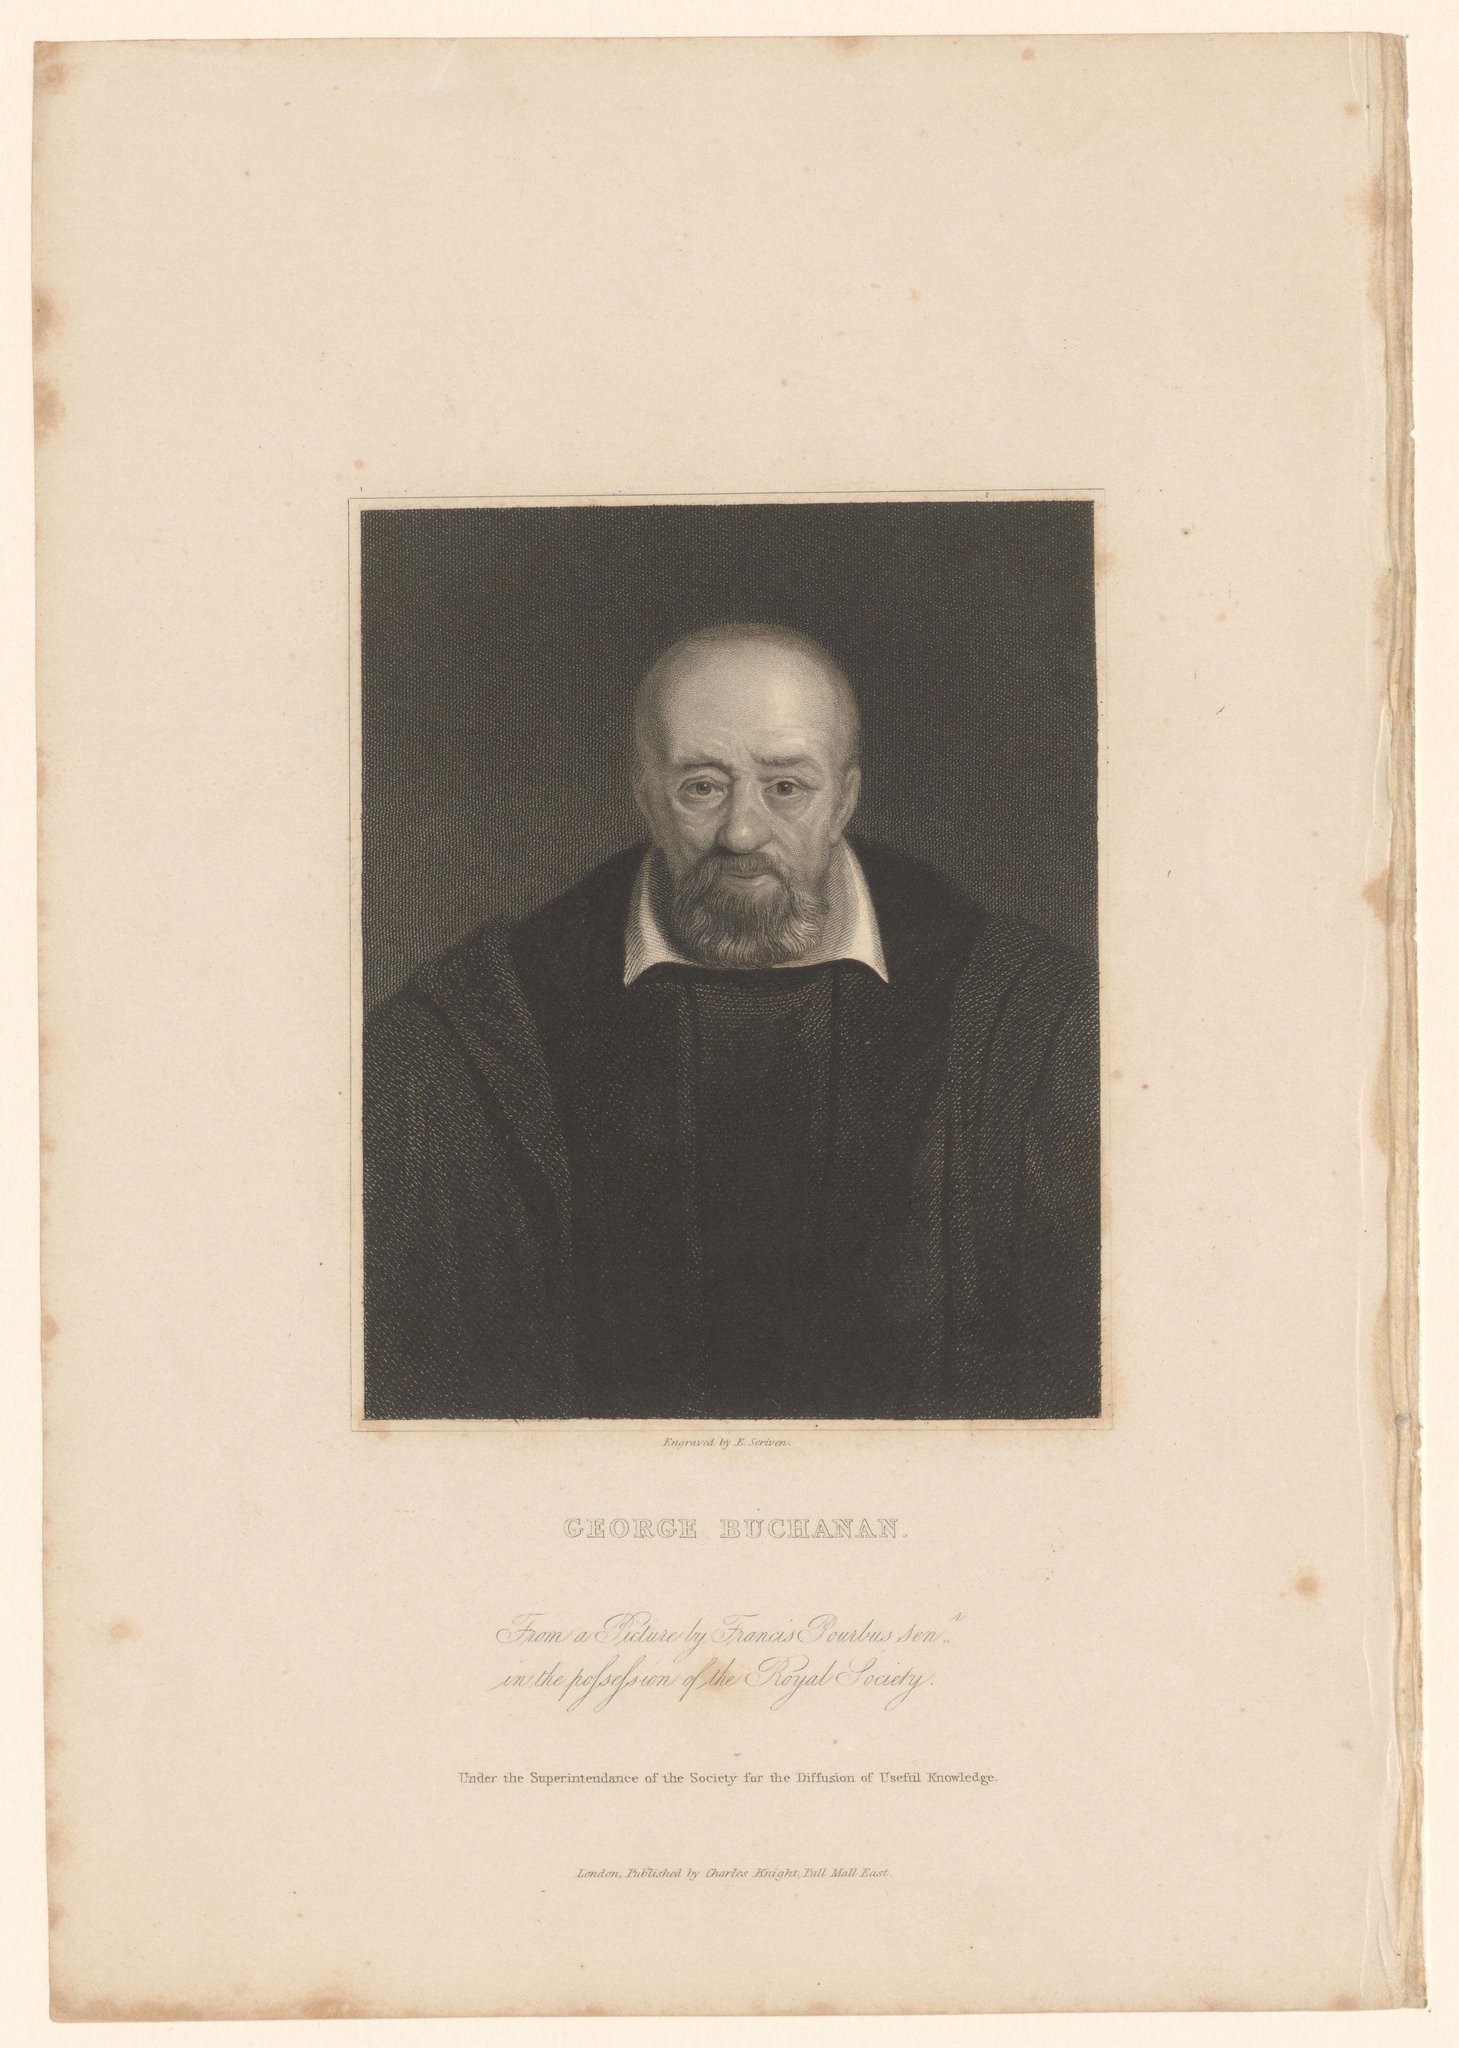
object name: print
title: Portret van George Buchanan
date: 1827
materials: paper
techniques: engraving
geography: london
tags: george buchanan, historical persons, portrait of a writer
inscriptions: collector's mark: Lugt 2228